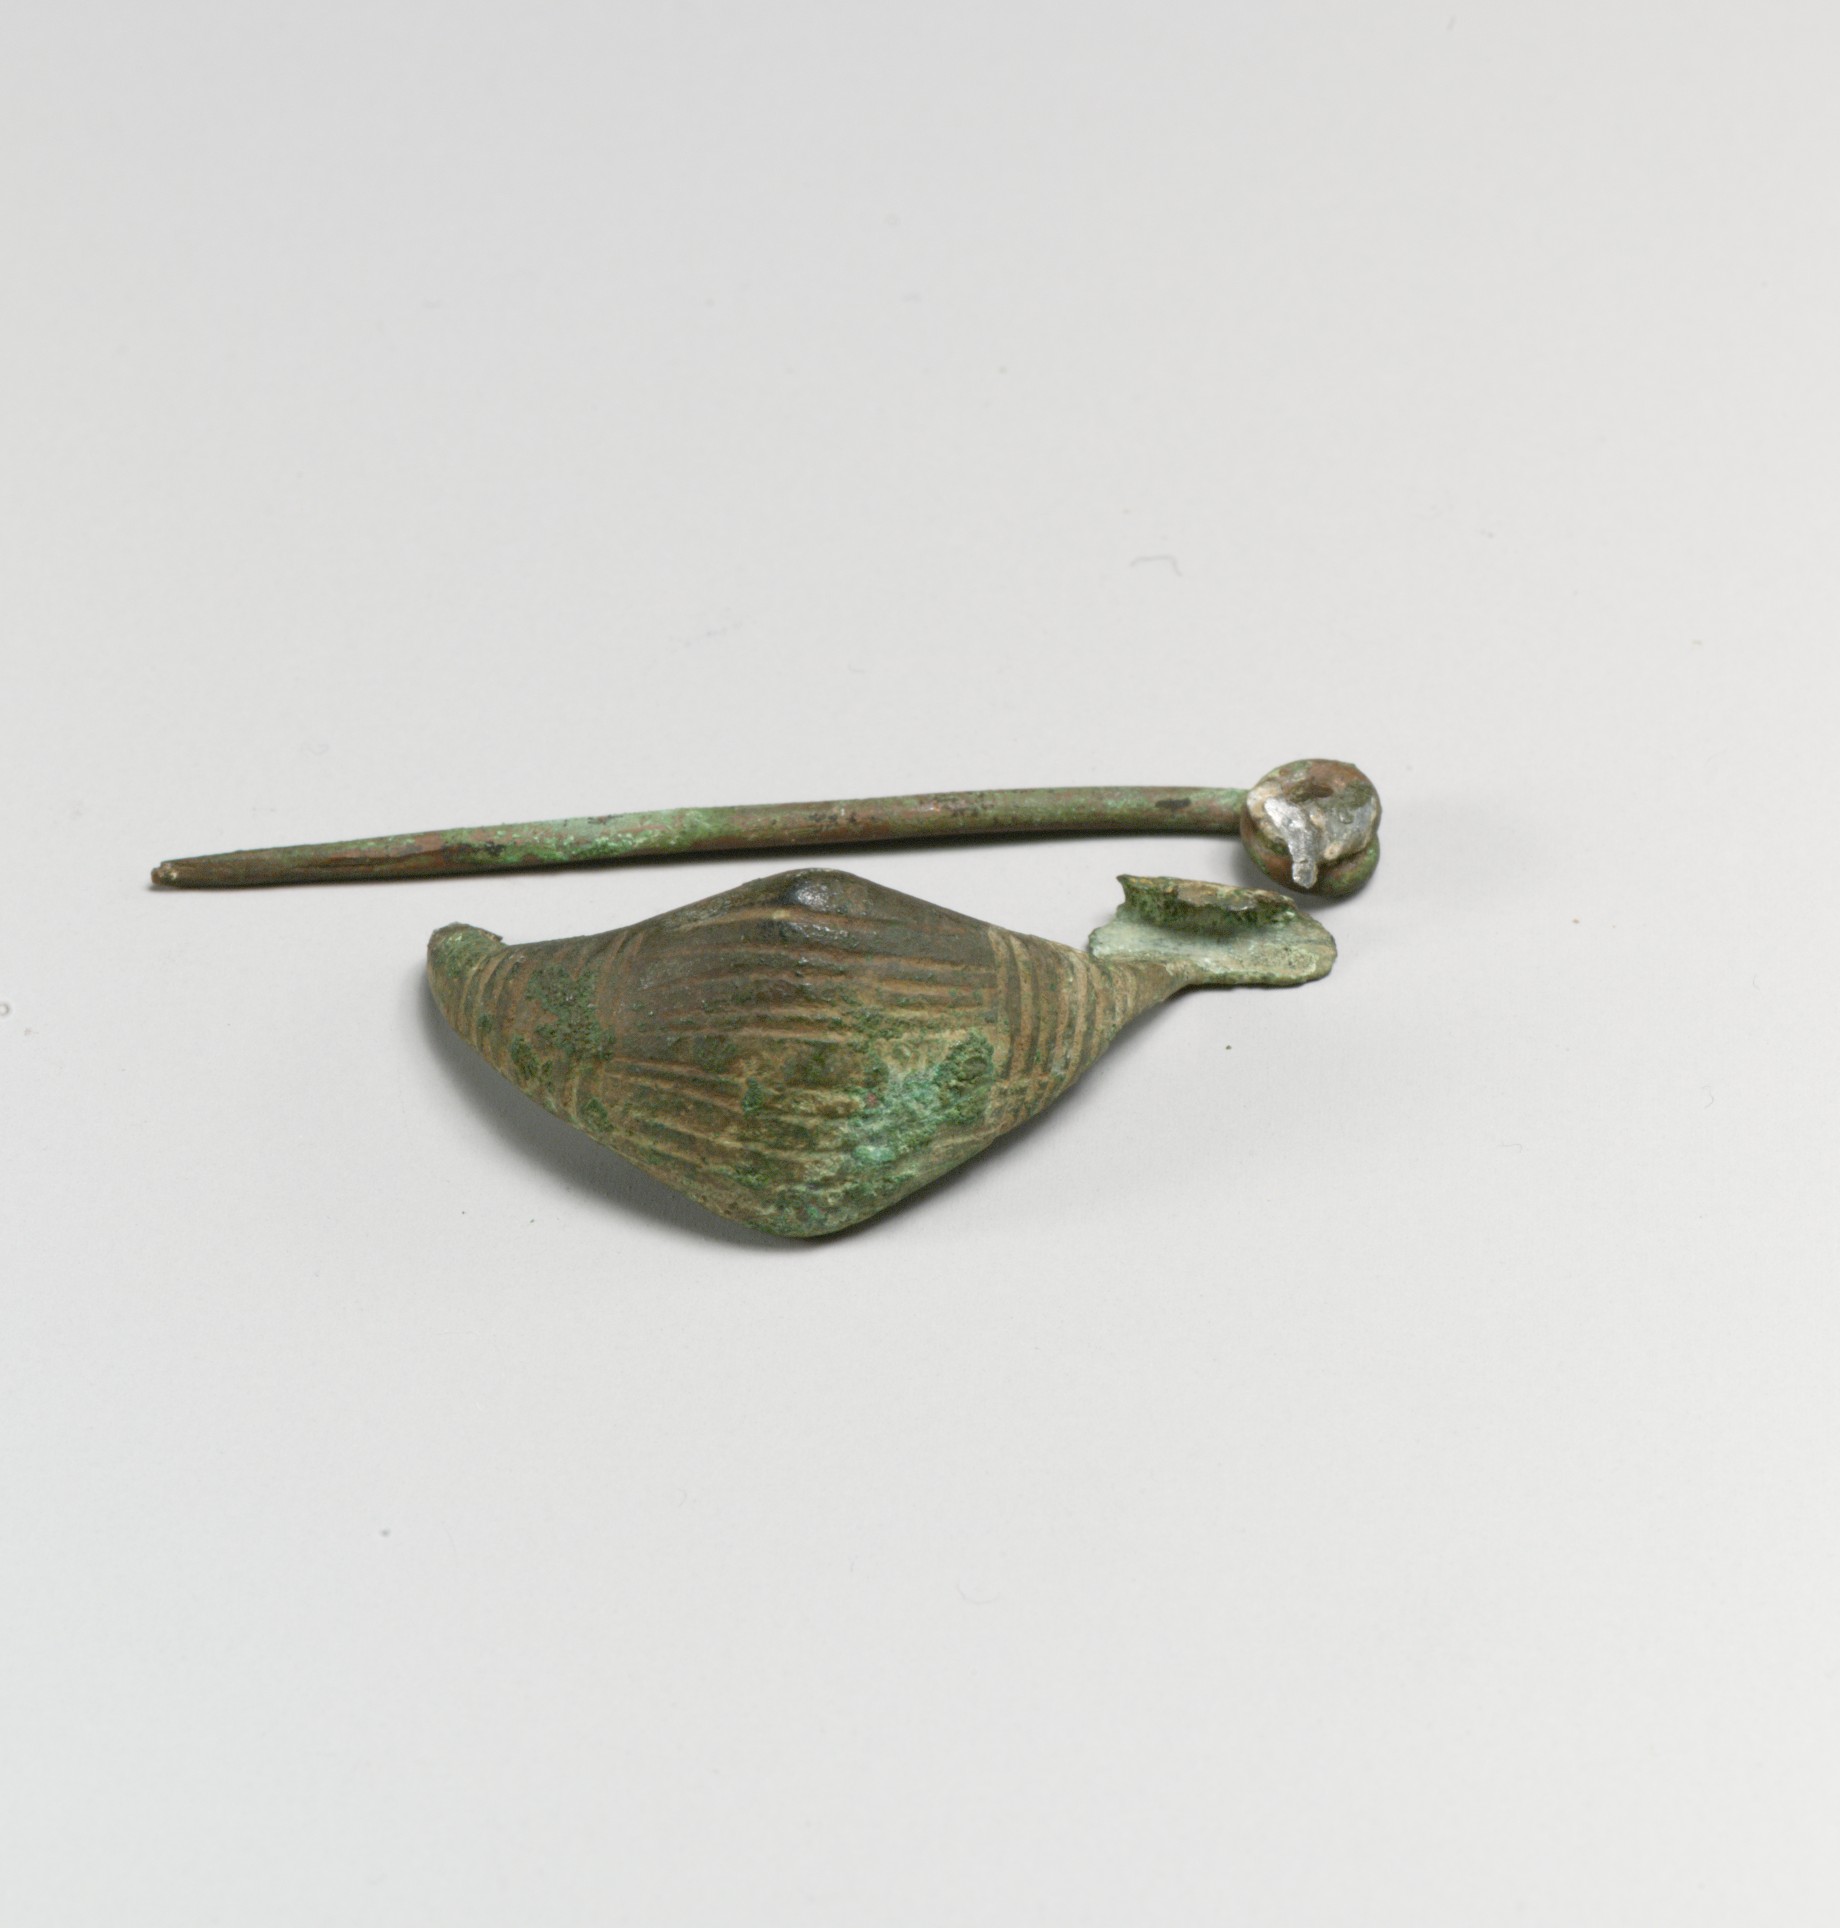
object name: fibula, boat shaped type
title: Fibula, boat-shaped type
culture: italic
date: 800-501 BCE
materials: bronze